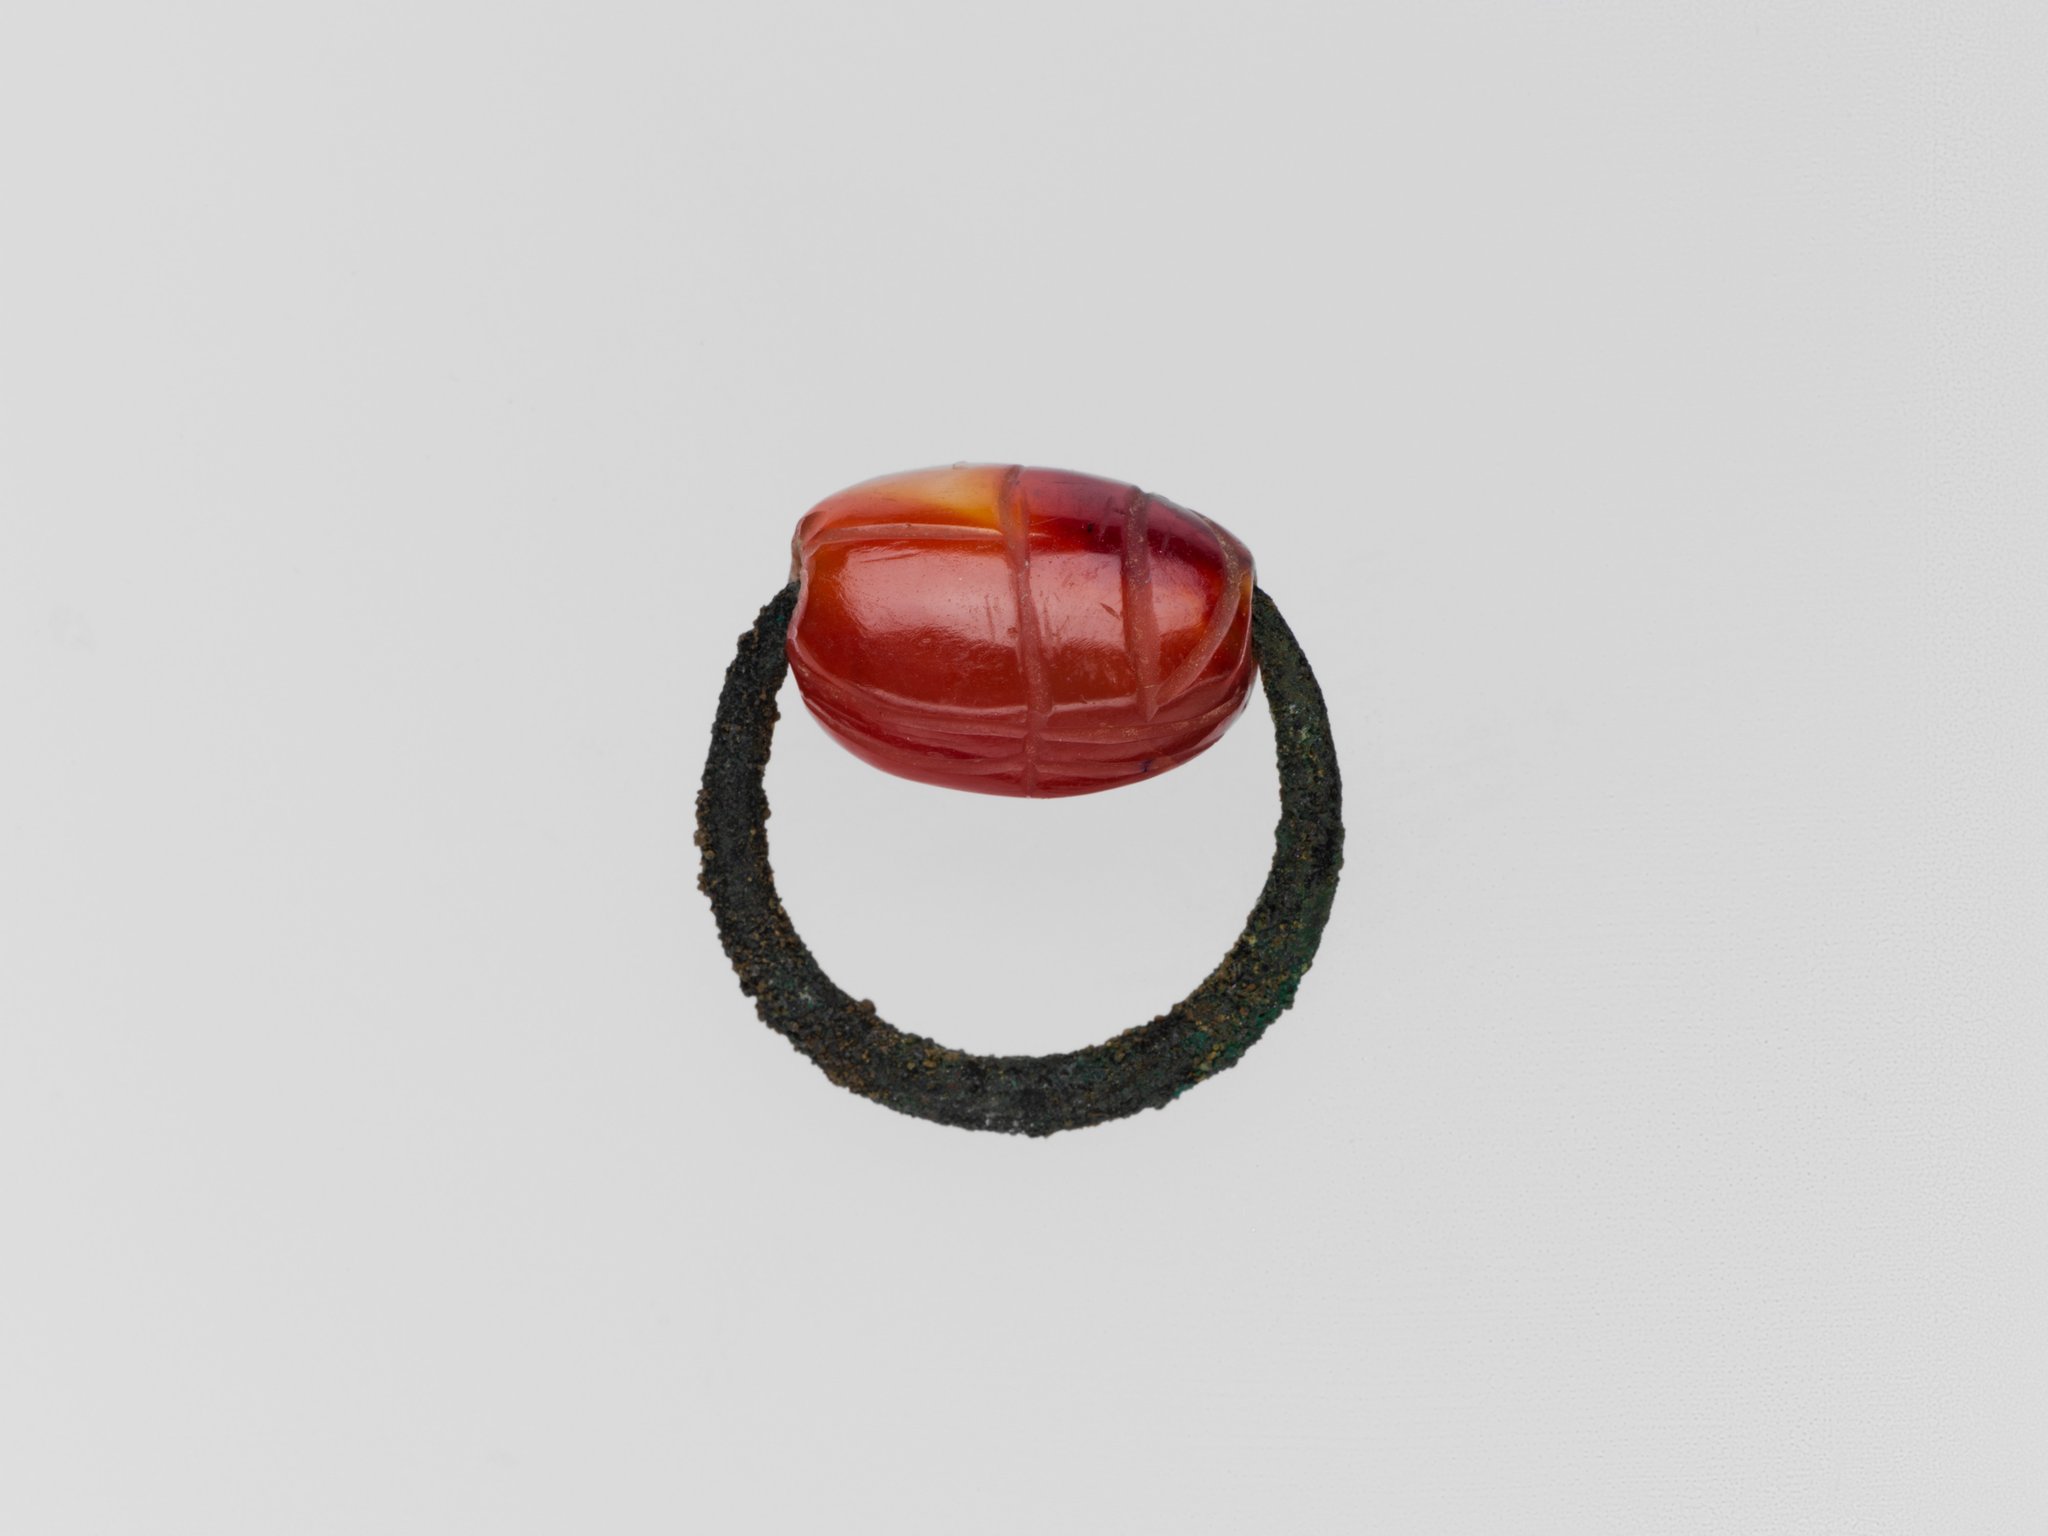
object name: ring with scarab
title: Bronze ring with carnelian scarab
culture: greek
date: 600-401 BCE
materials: bronze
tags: scarabs